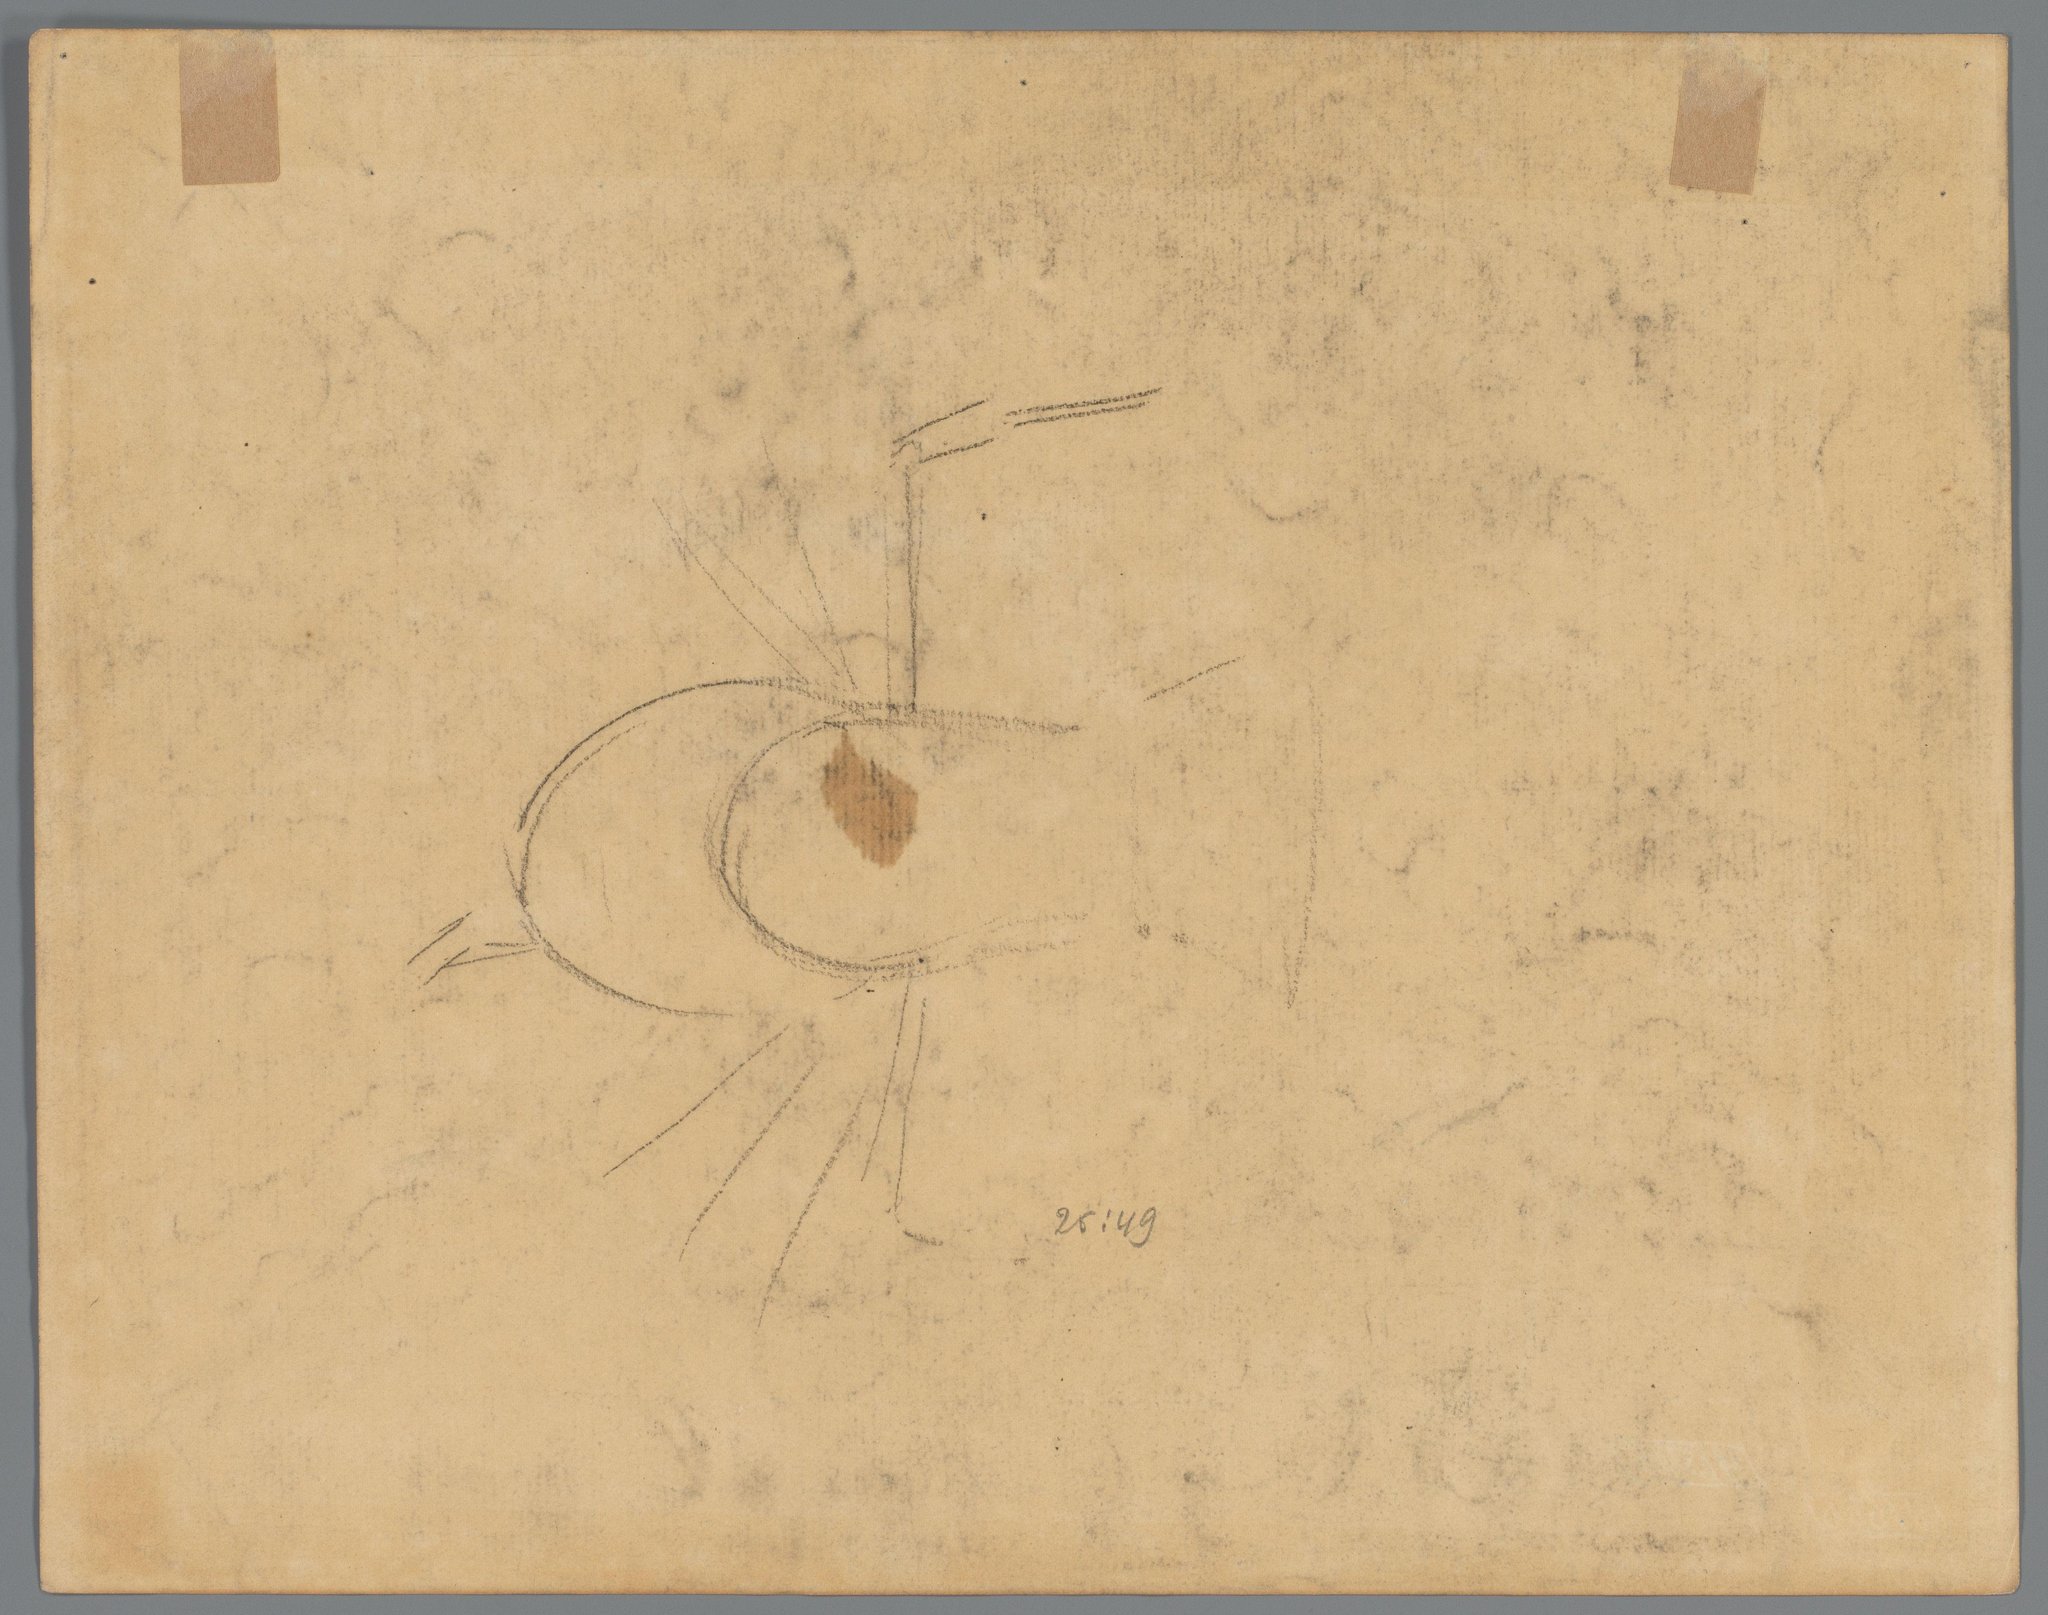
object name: drawing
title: Studie, mogelijk de omtrek van een kreeft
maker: gerrit willem dijsselhof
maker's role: designer, draughtsman, print maker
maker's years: 1866-1924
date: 1876-1924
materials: chalk, paper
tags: crustaceans: lobster